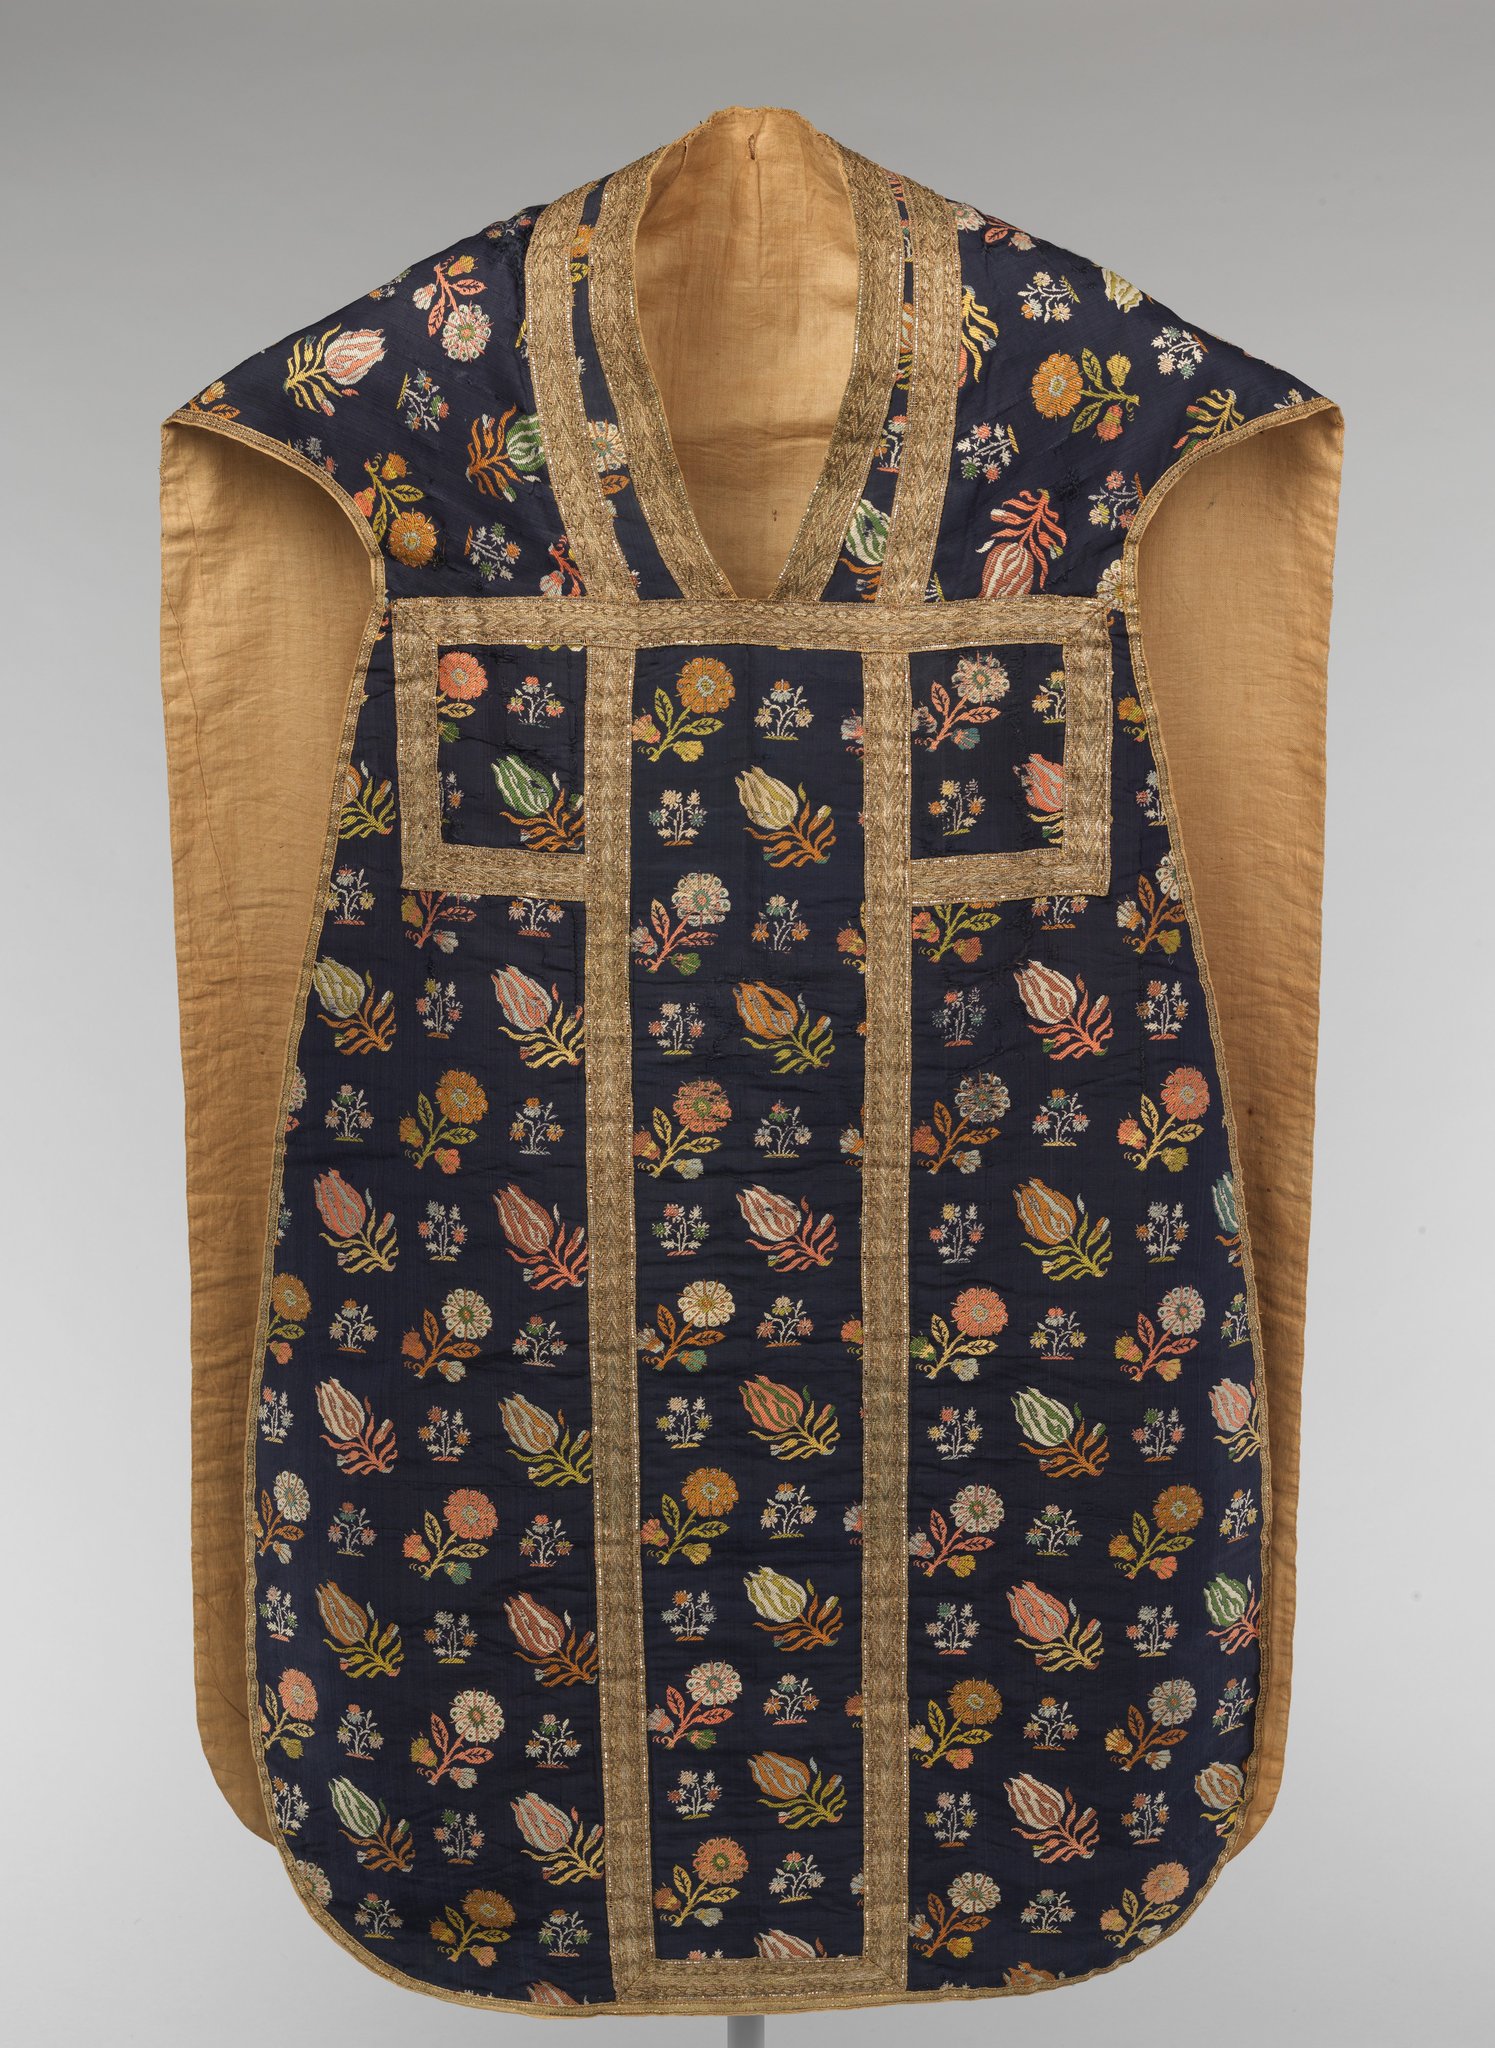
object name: chasuble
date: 1634-1666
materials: silk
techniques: brocade, weave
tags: flowers